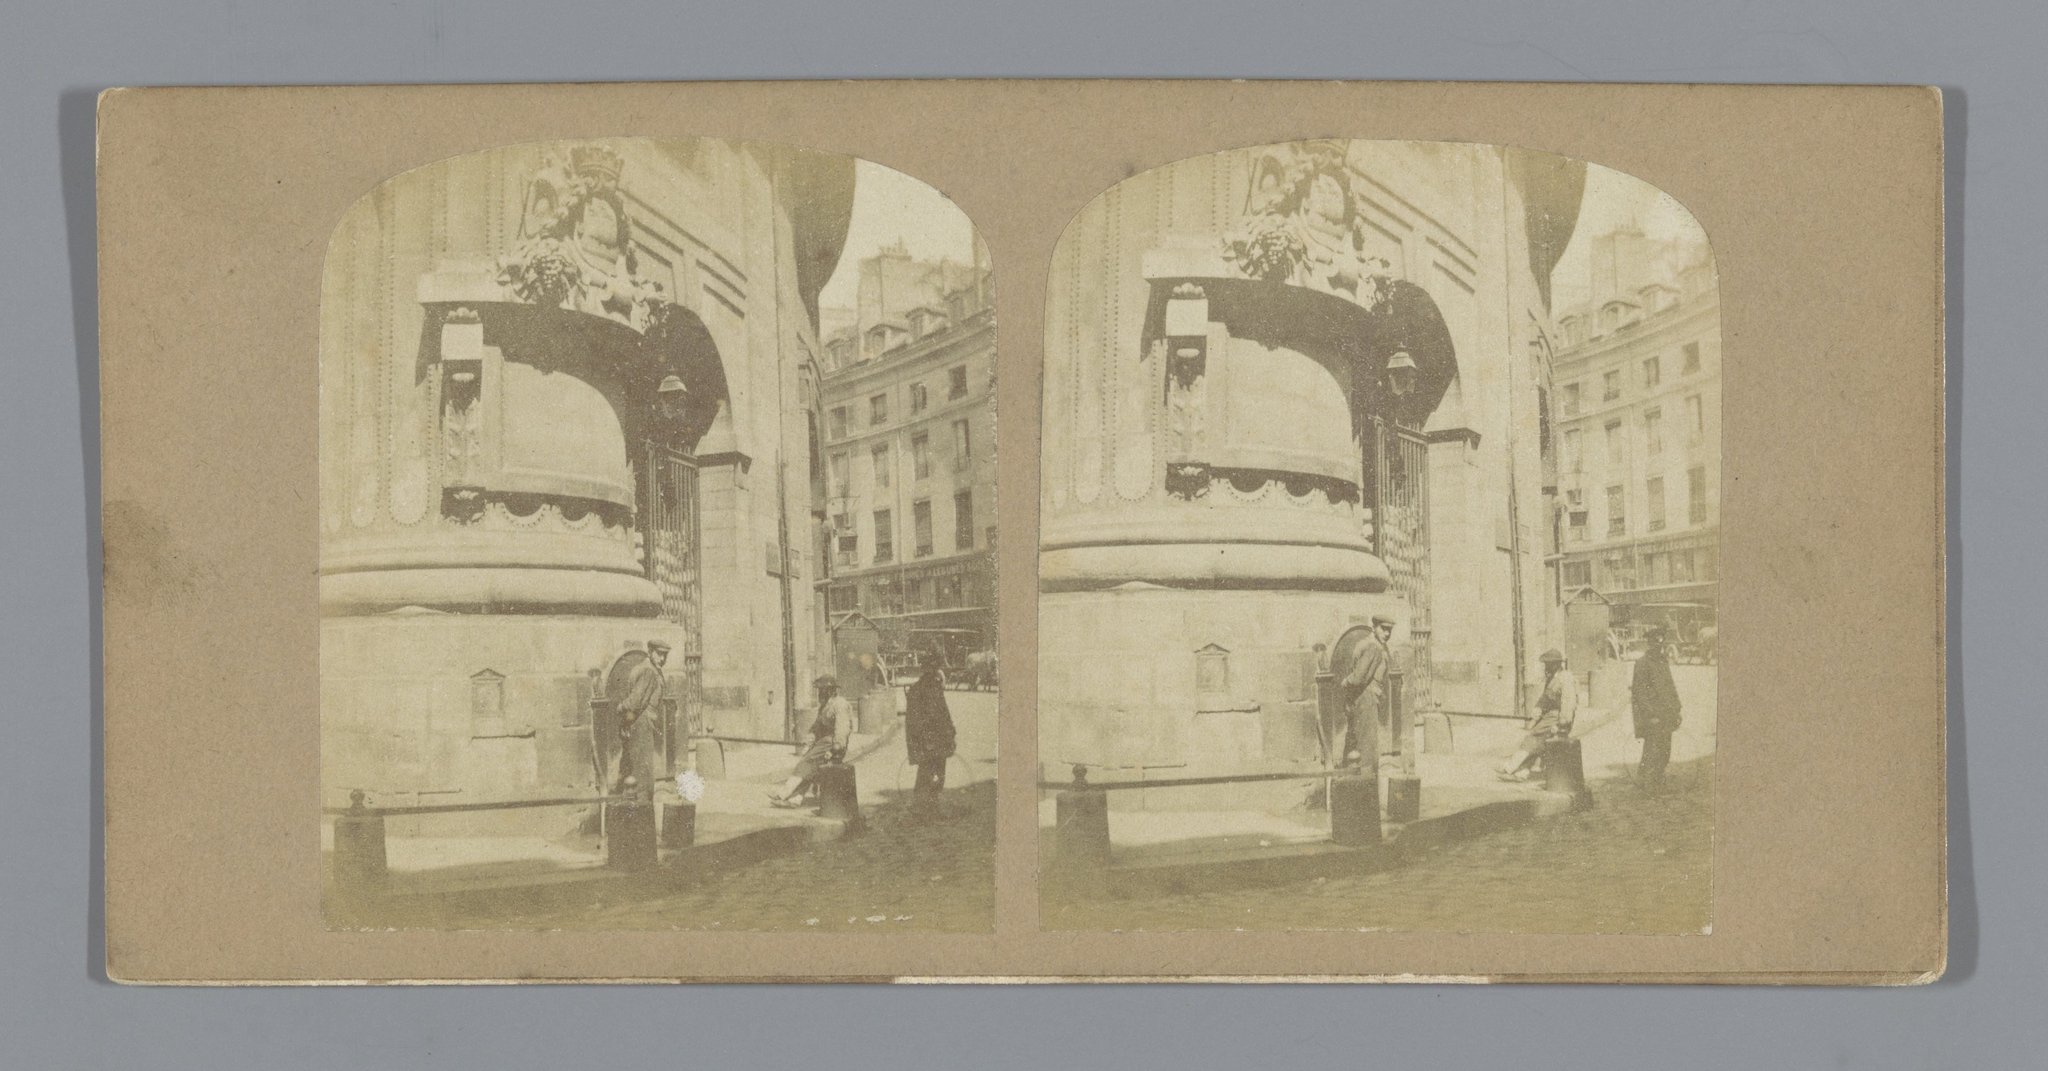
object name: stereograph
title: Mannen in een straat te Parijs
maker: Anonymous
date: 1850-1875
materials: cardboard, photographic support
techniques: albumen print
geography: paris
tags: façade (of house or building), street